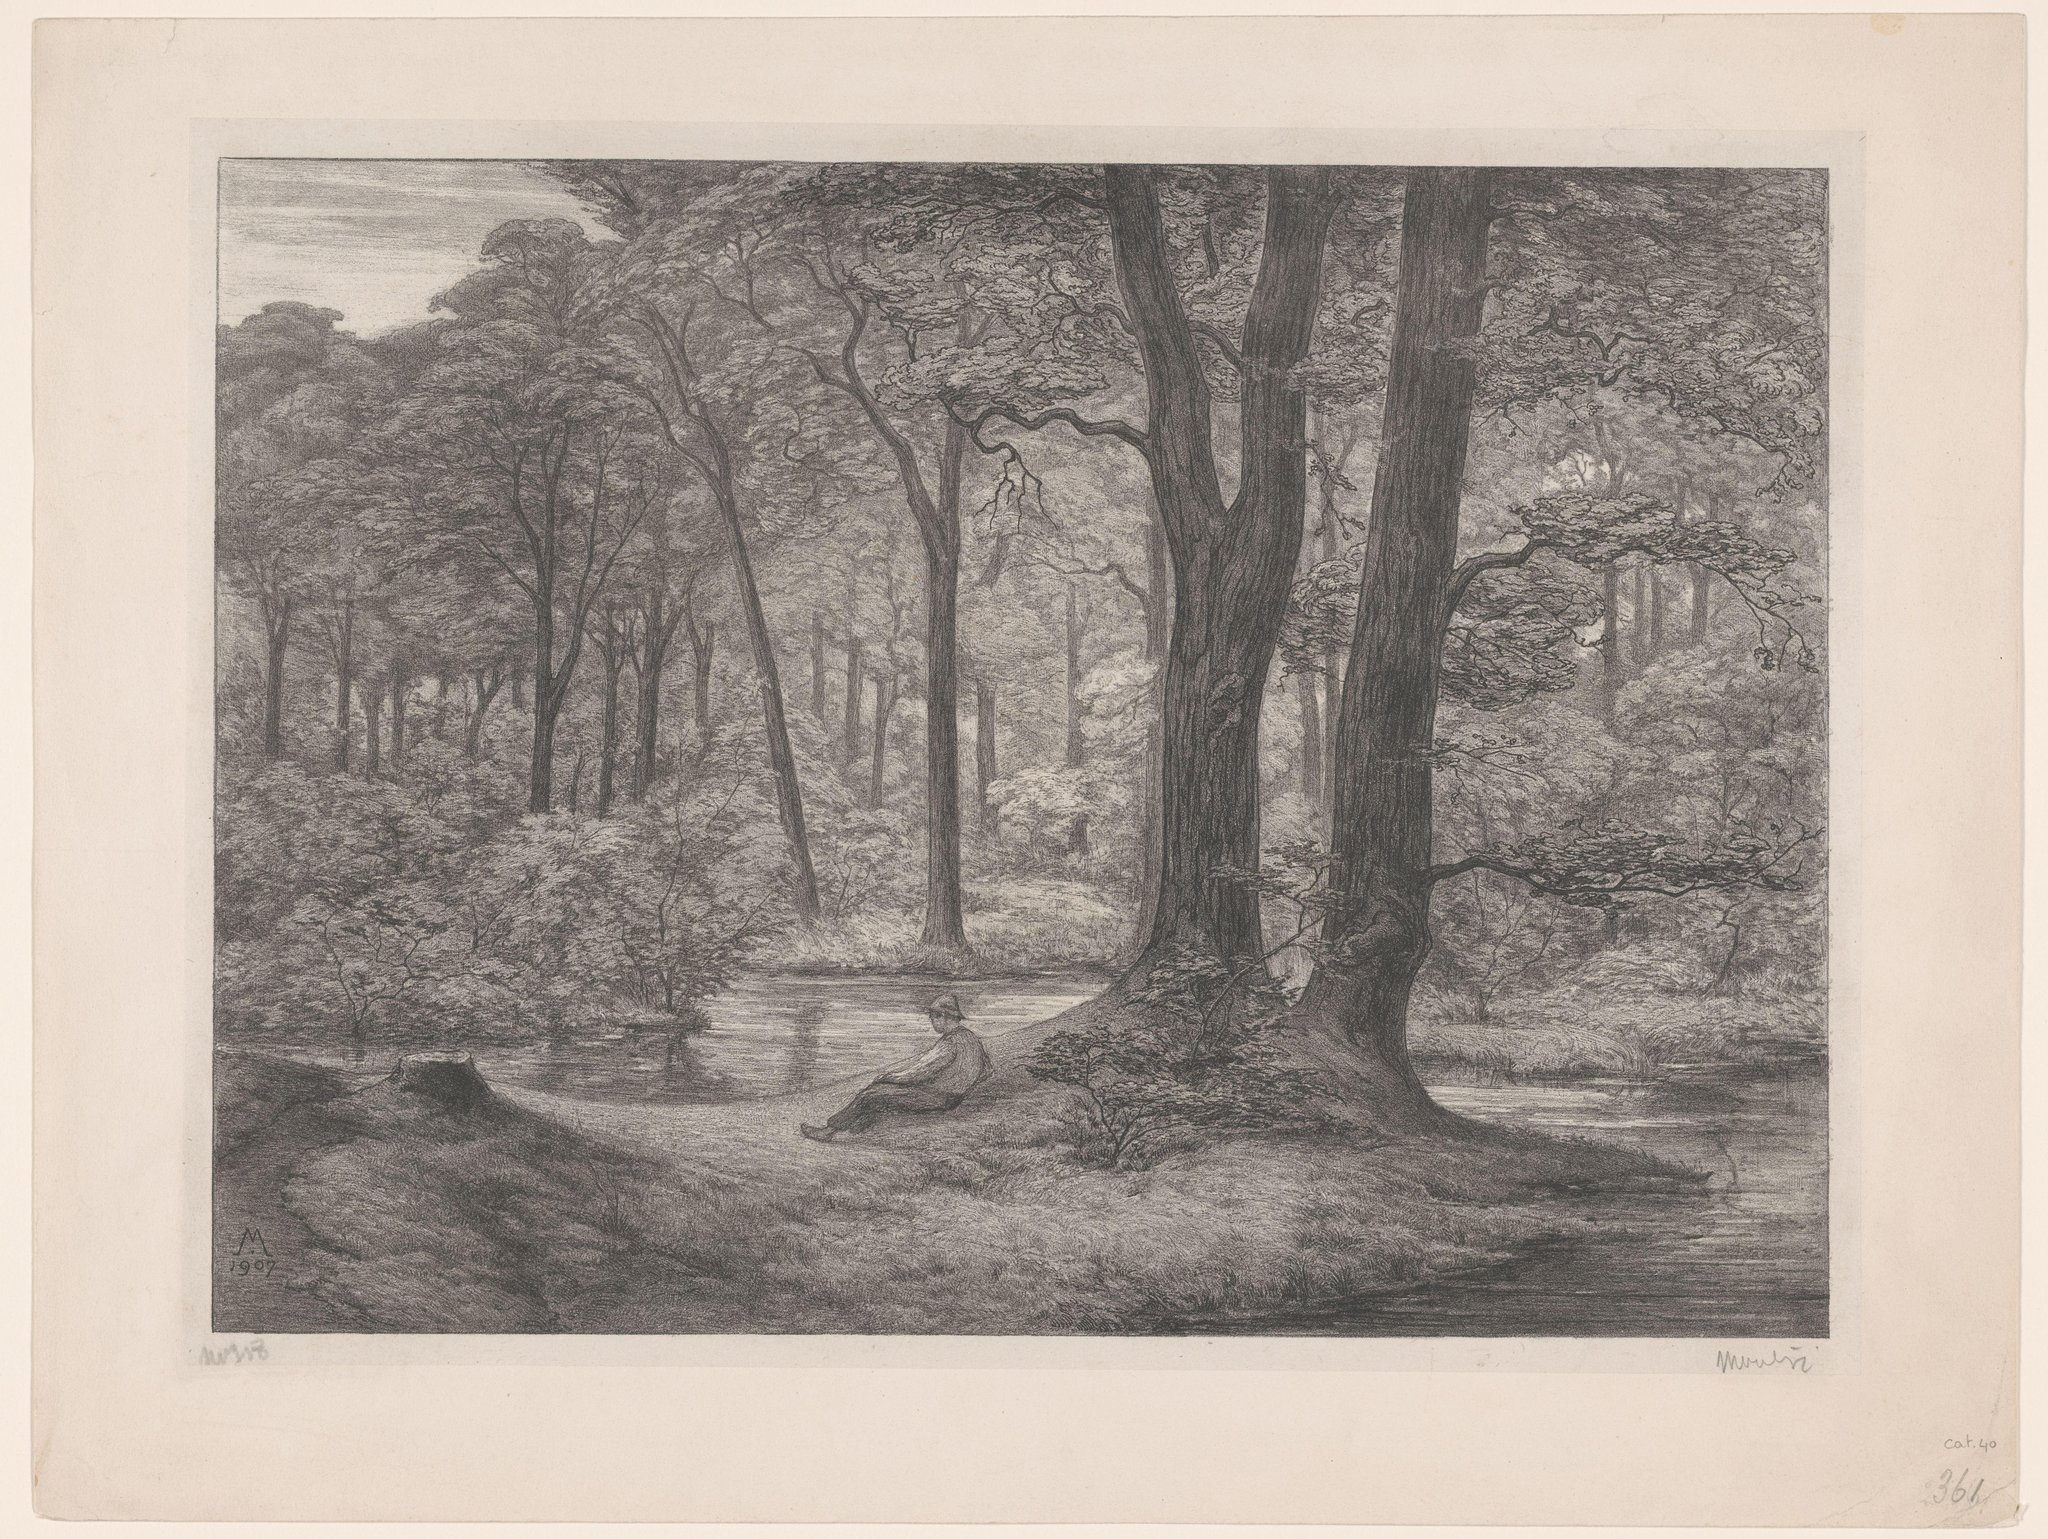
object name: print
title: Teutoburgerwoud (boschgezicht)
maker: simon moulijn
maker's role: draughtsman, print maker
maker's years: 1866-1948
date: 1907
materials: paper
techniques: lithograph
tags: forest, wood, pond, pool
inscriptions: date